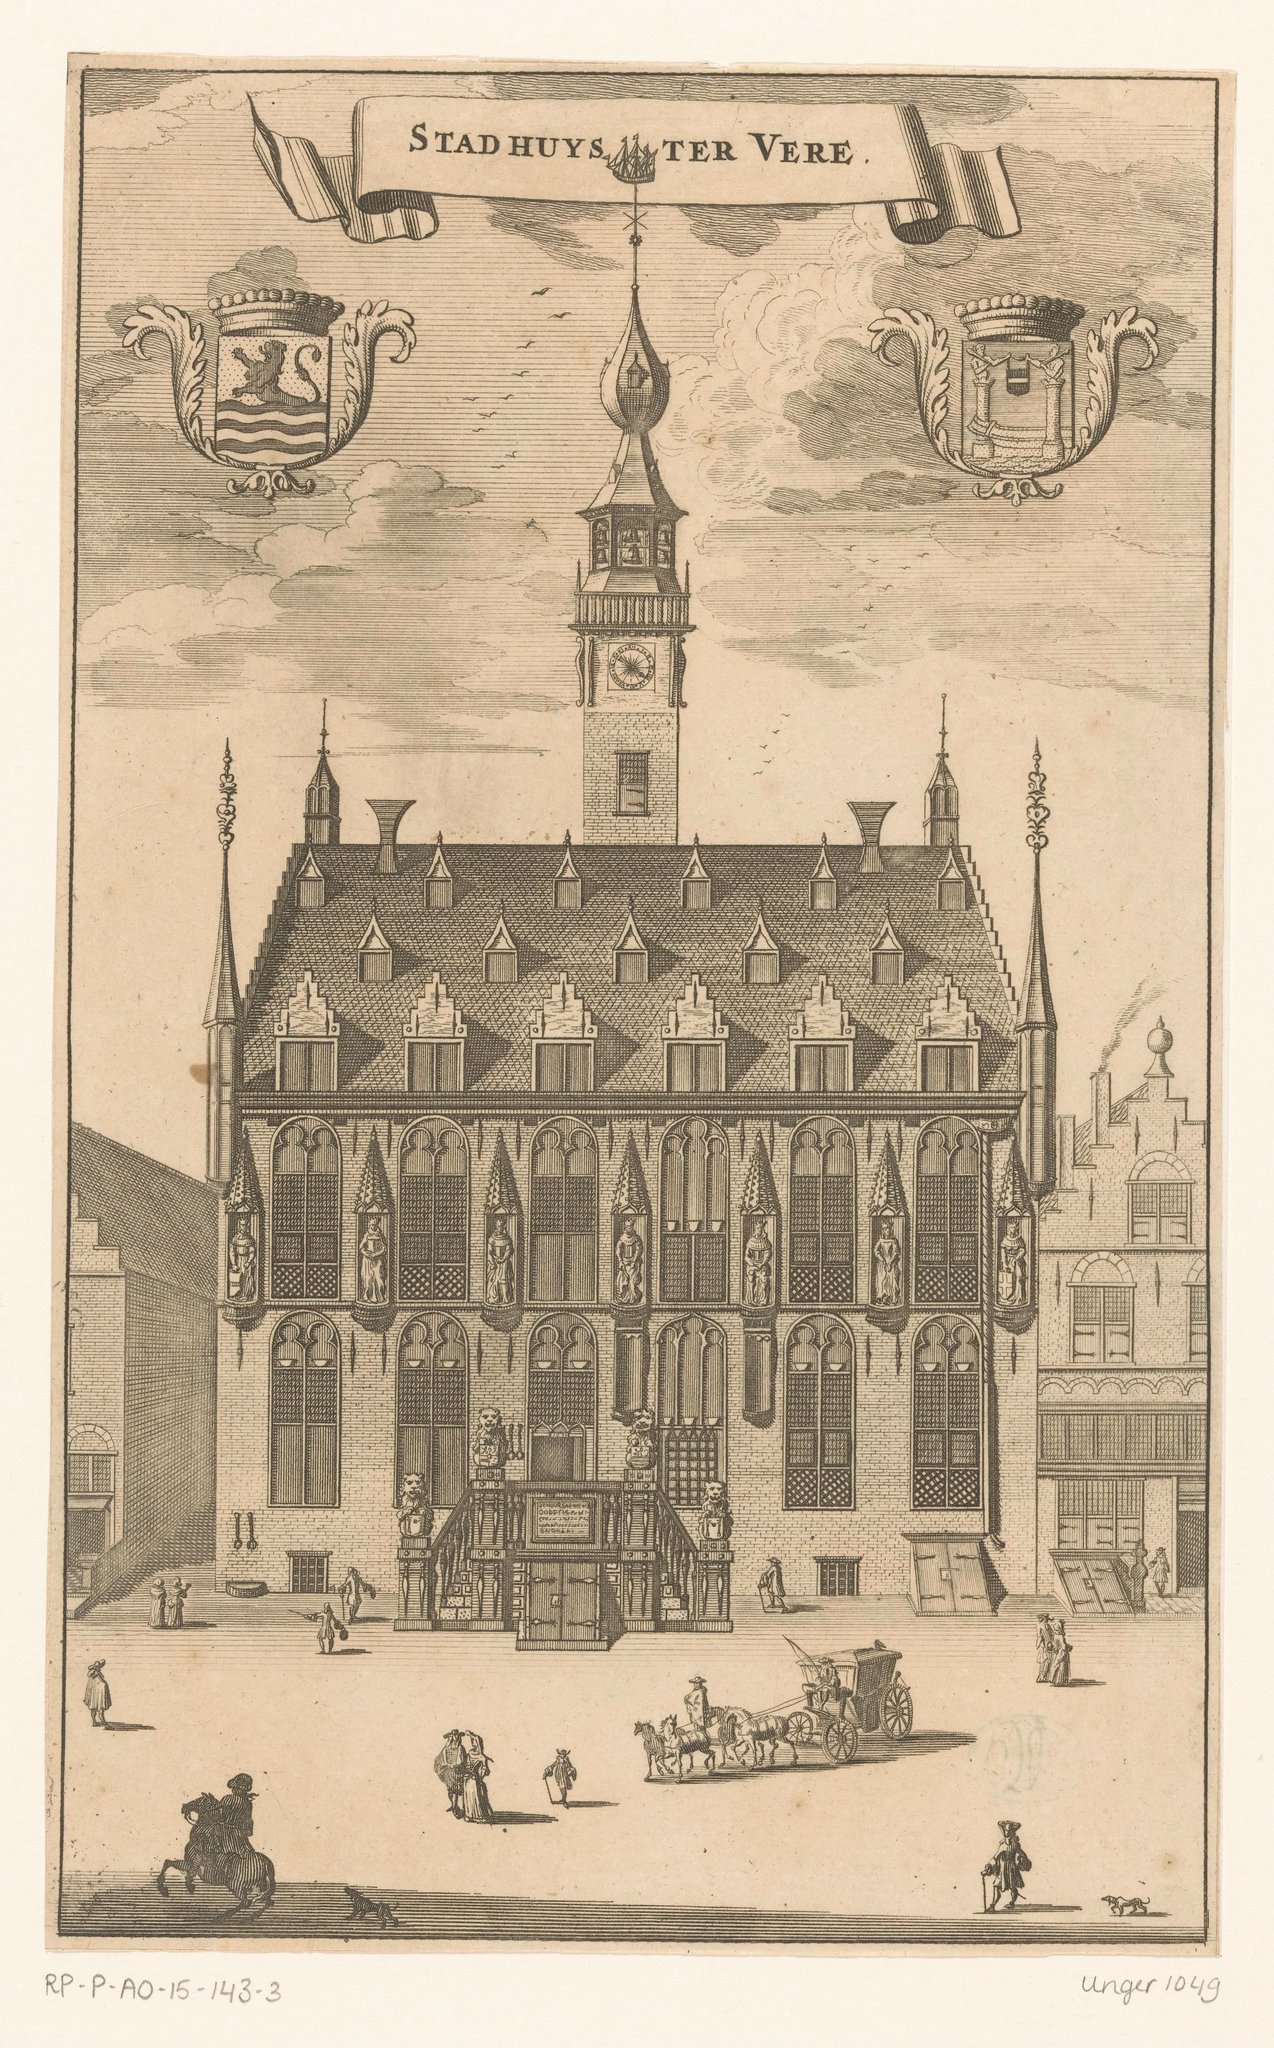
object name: print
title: Stadhuys ter Vere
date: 1696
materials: paper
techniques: engraving, etching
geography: amsterdam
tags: coat of arms (as symbol of the state, etc.) (+ city; municipal), townhall, coat of arms (as symbol of the state, etc.) (+ province; provincial)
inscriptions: collector's mark: Lugt 195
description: Oorspronkelijk van één plaat gedrukt met één andere voorstelling (zie RP-P-AO-15-75). Prent in zijn geheel ook gebruikt in: Smallegange, Mattheus. Nieuwe Cronyk van Zeeland (…). Middelburg en Amsterdam: Johannes Meertens en Abraham van Someren, 1696. Huidige voorstelling later (plaat versneden tot twee platen) ook gebruikt in: Aa, Pieter van der. La galerie agreable du monde (...). 66 delen. Leiden: Pieter van der Aa, 1728, dl. 21.